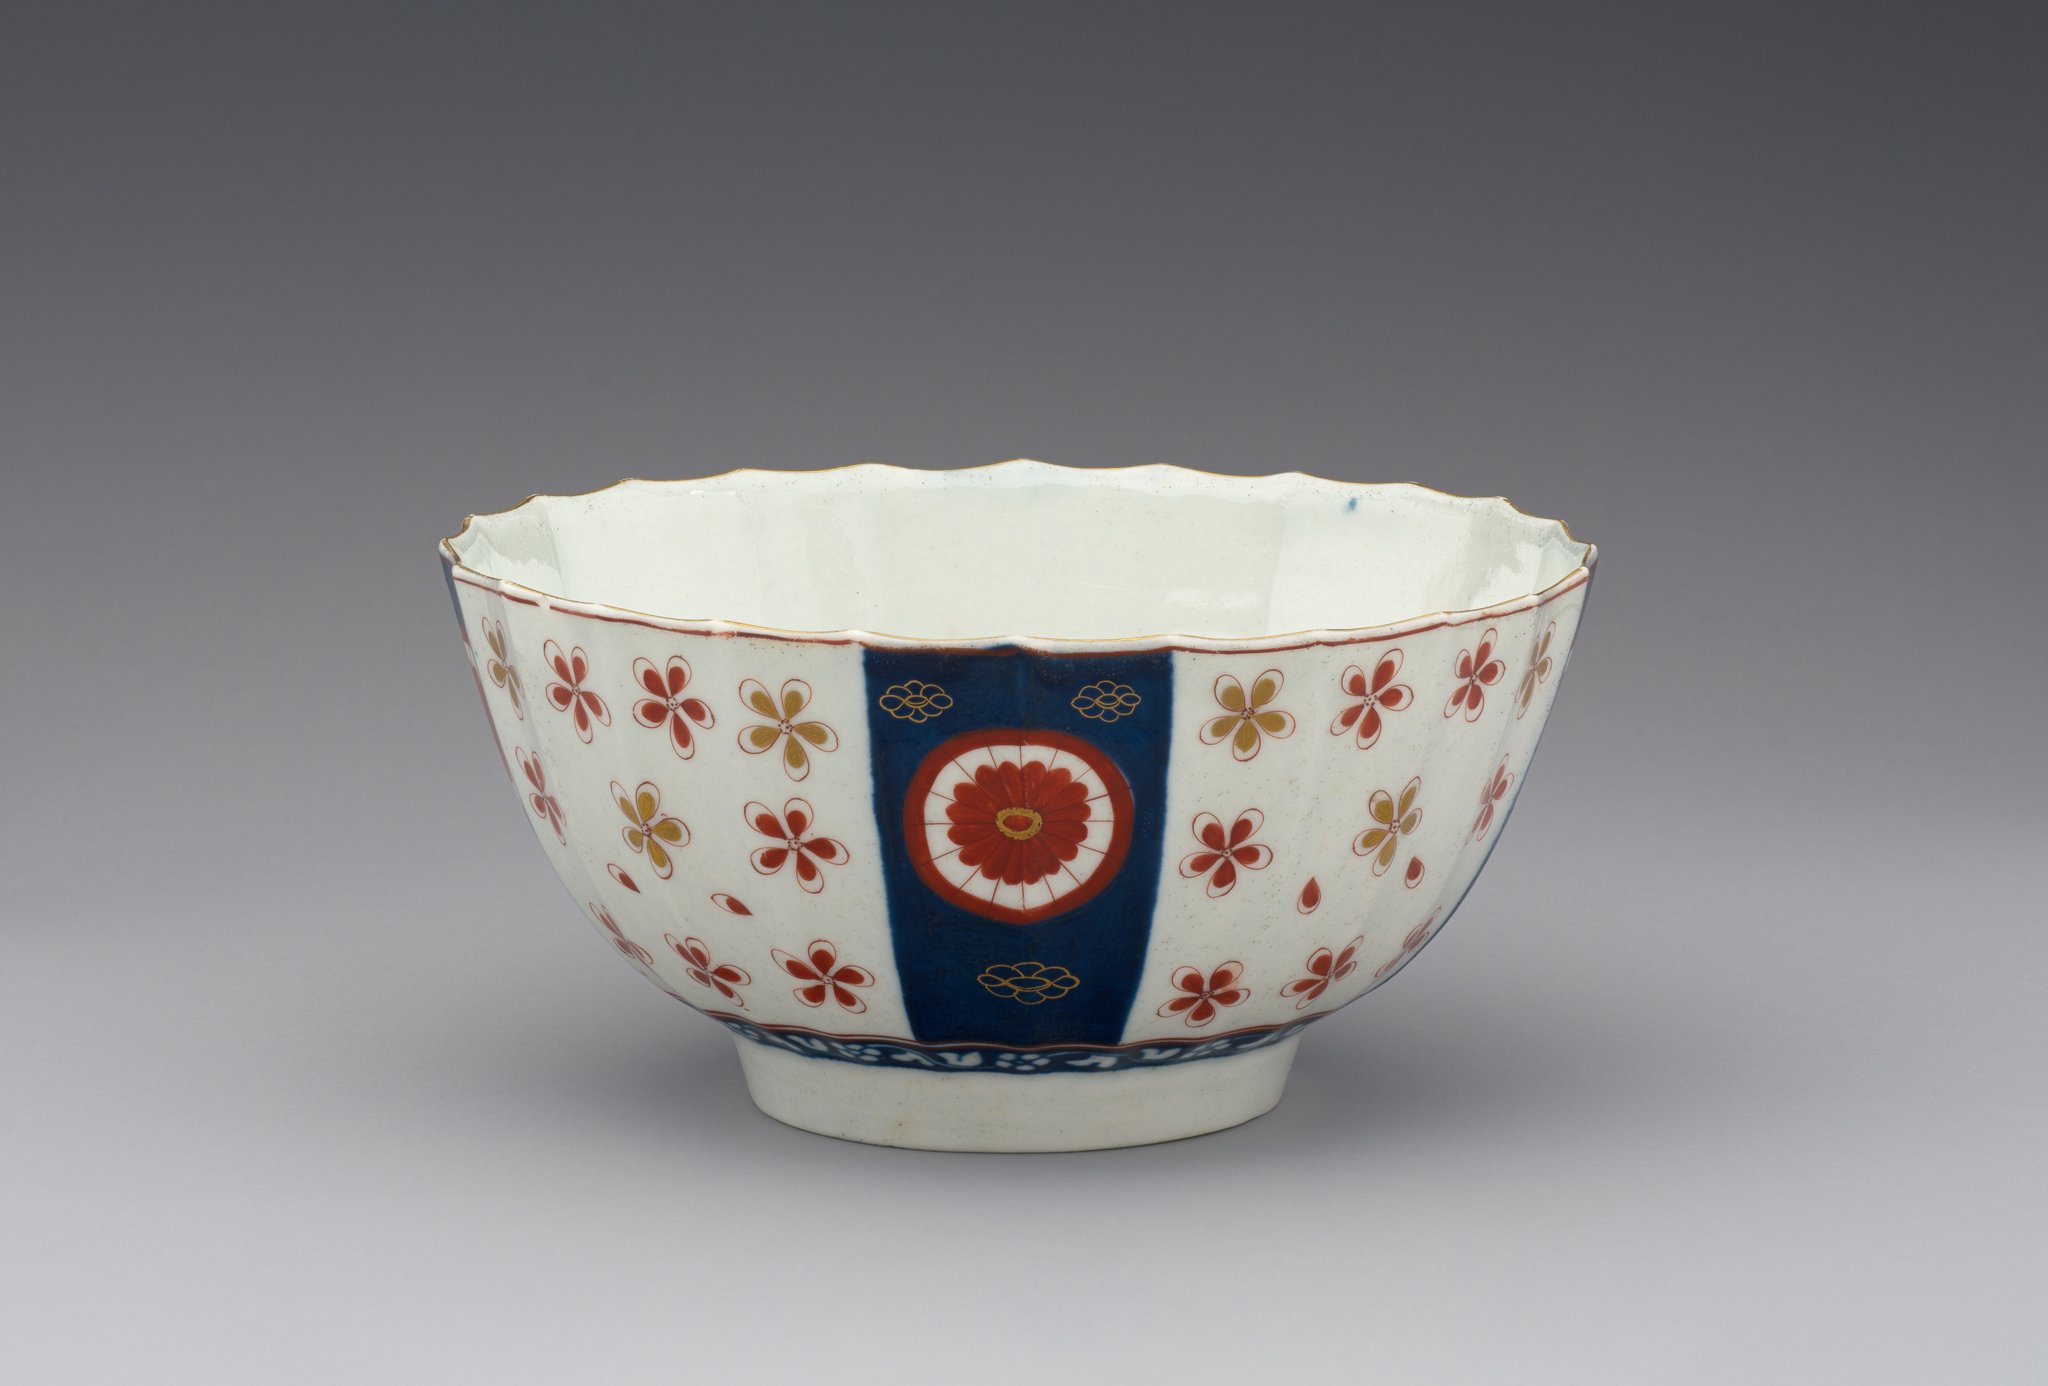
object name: bowl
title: Bowl (part of a service)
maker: worcester factory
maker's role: factory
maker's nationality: british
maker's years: 1751-2008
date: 1765-1775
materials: soft paste porcelain